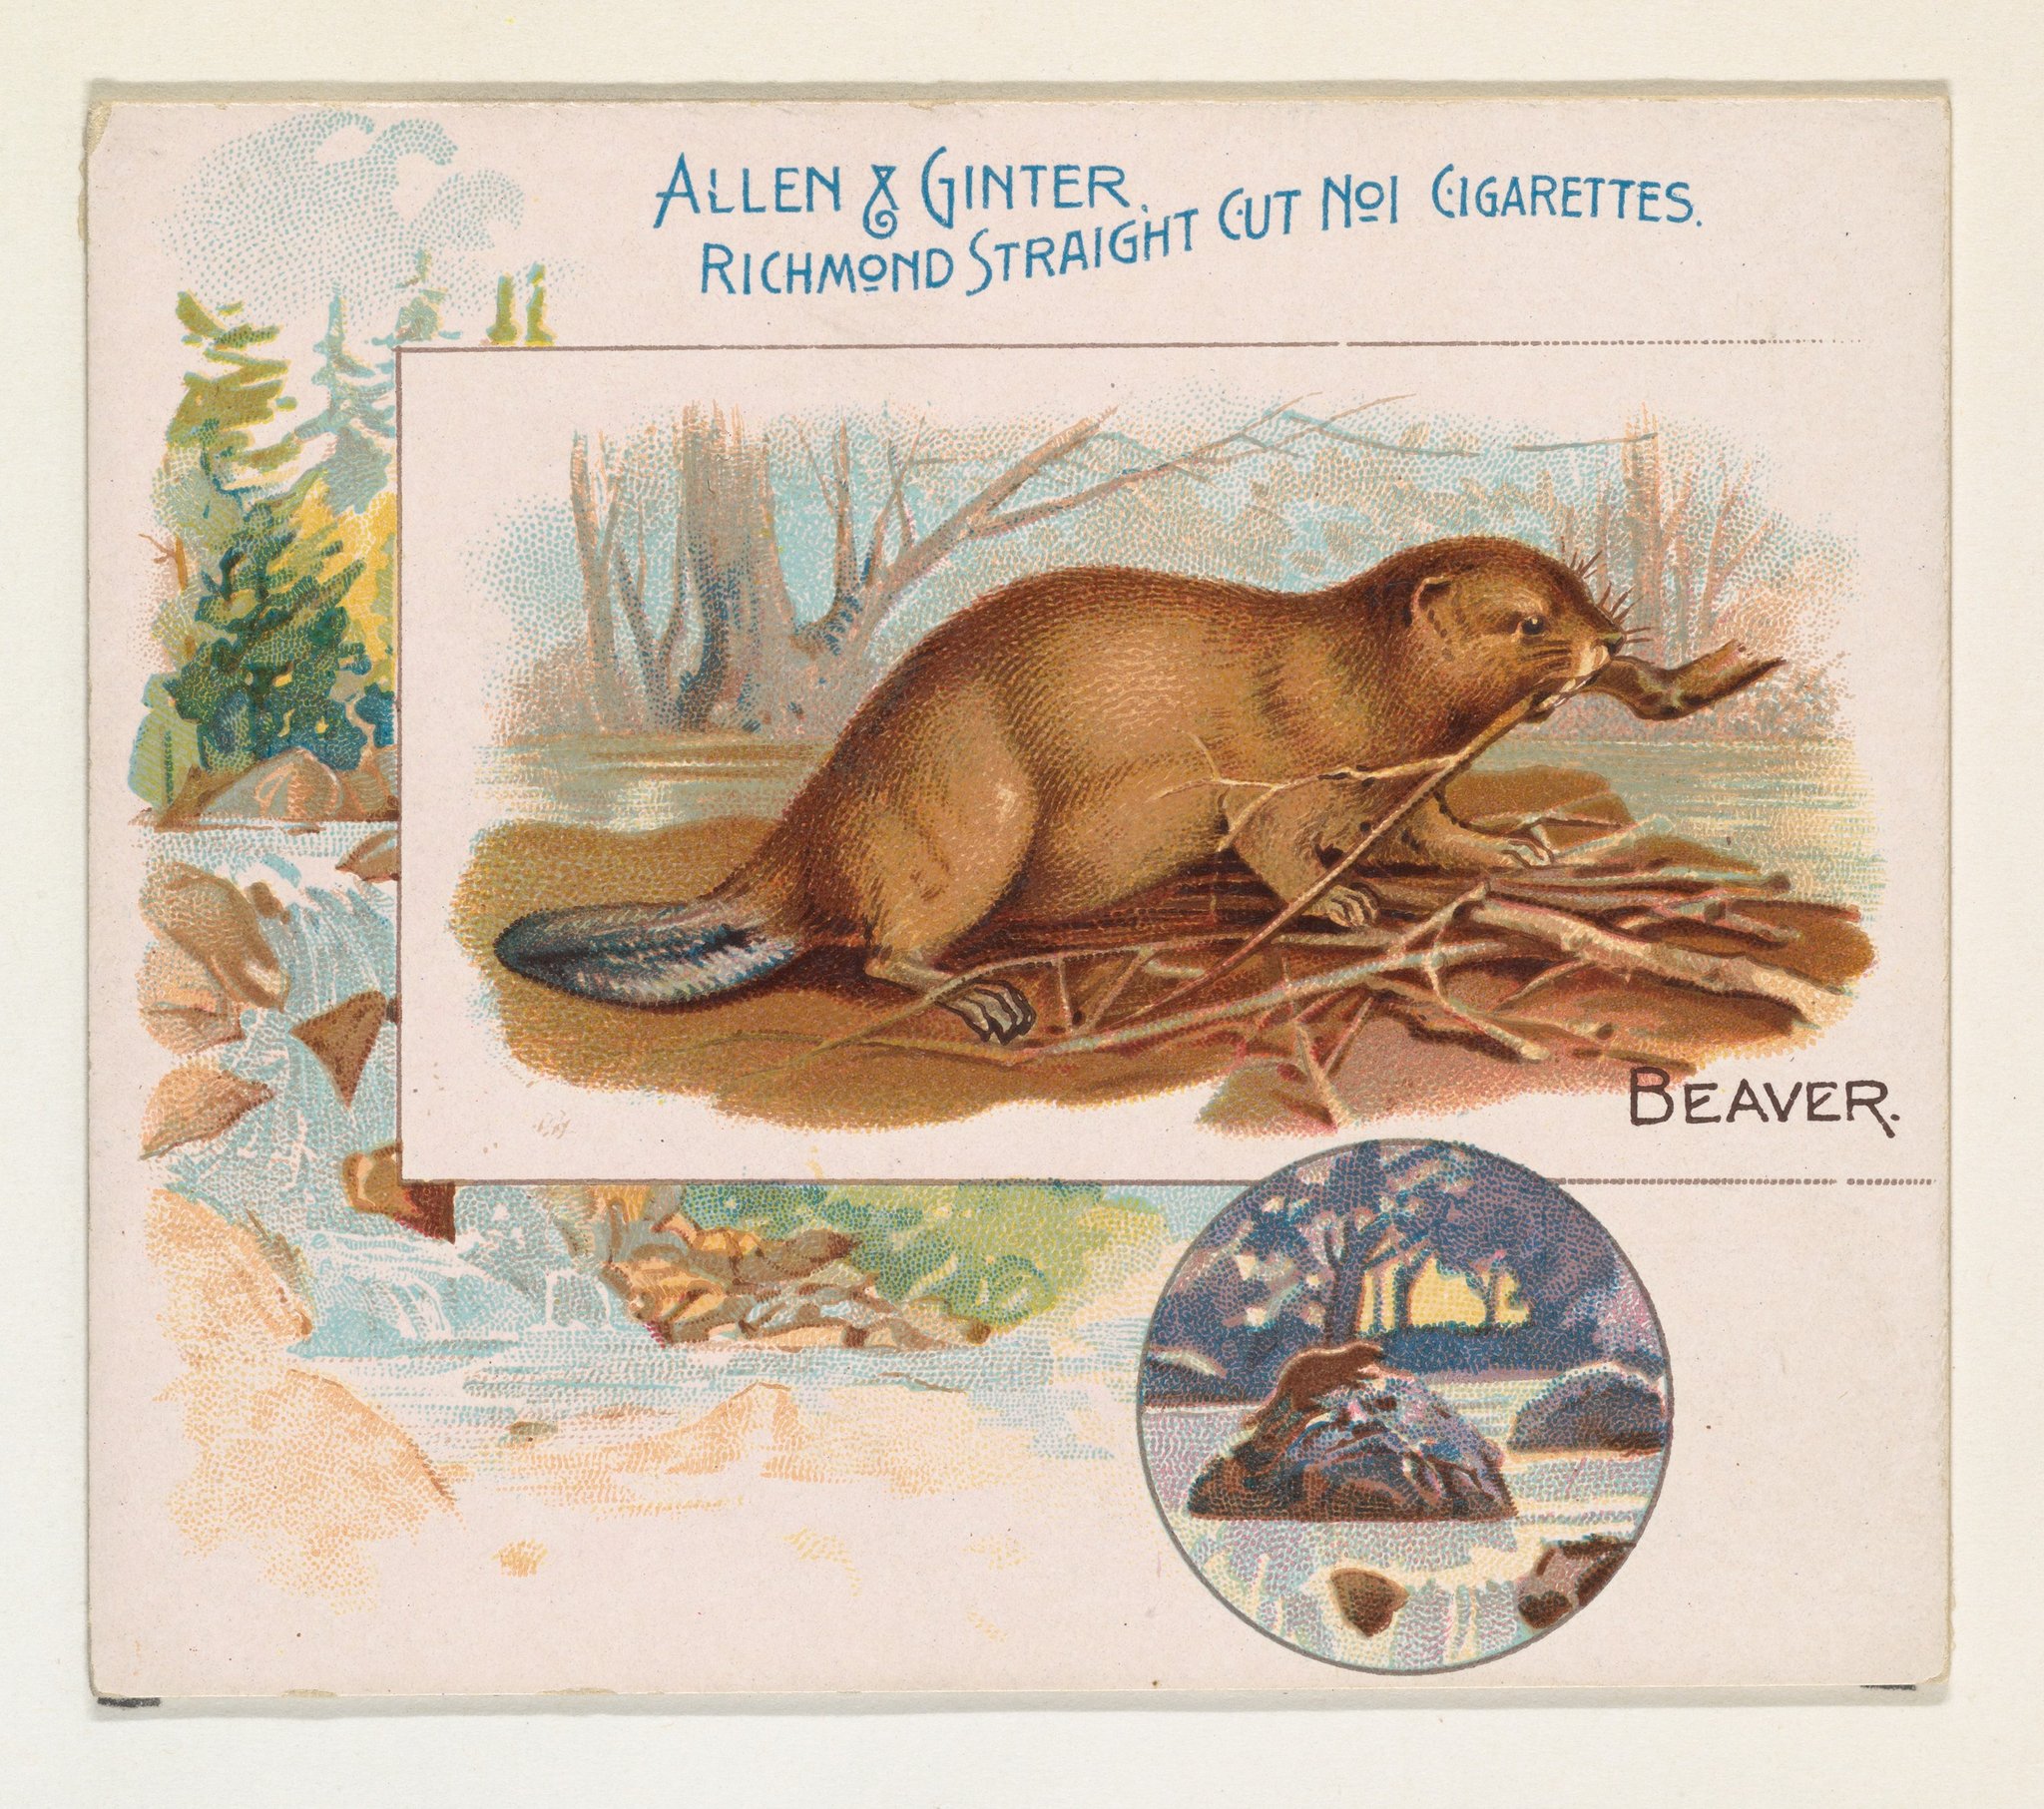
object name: print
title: Beaver, from Quadrupeds series (N41) for Allen & Ginter Cigarettes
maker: allen & ginter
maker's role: publisher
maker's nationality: american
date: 1890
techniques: color lithograph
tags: animals